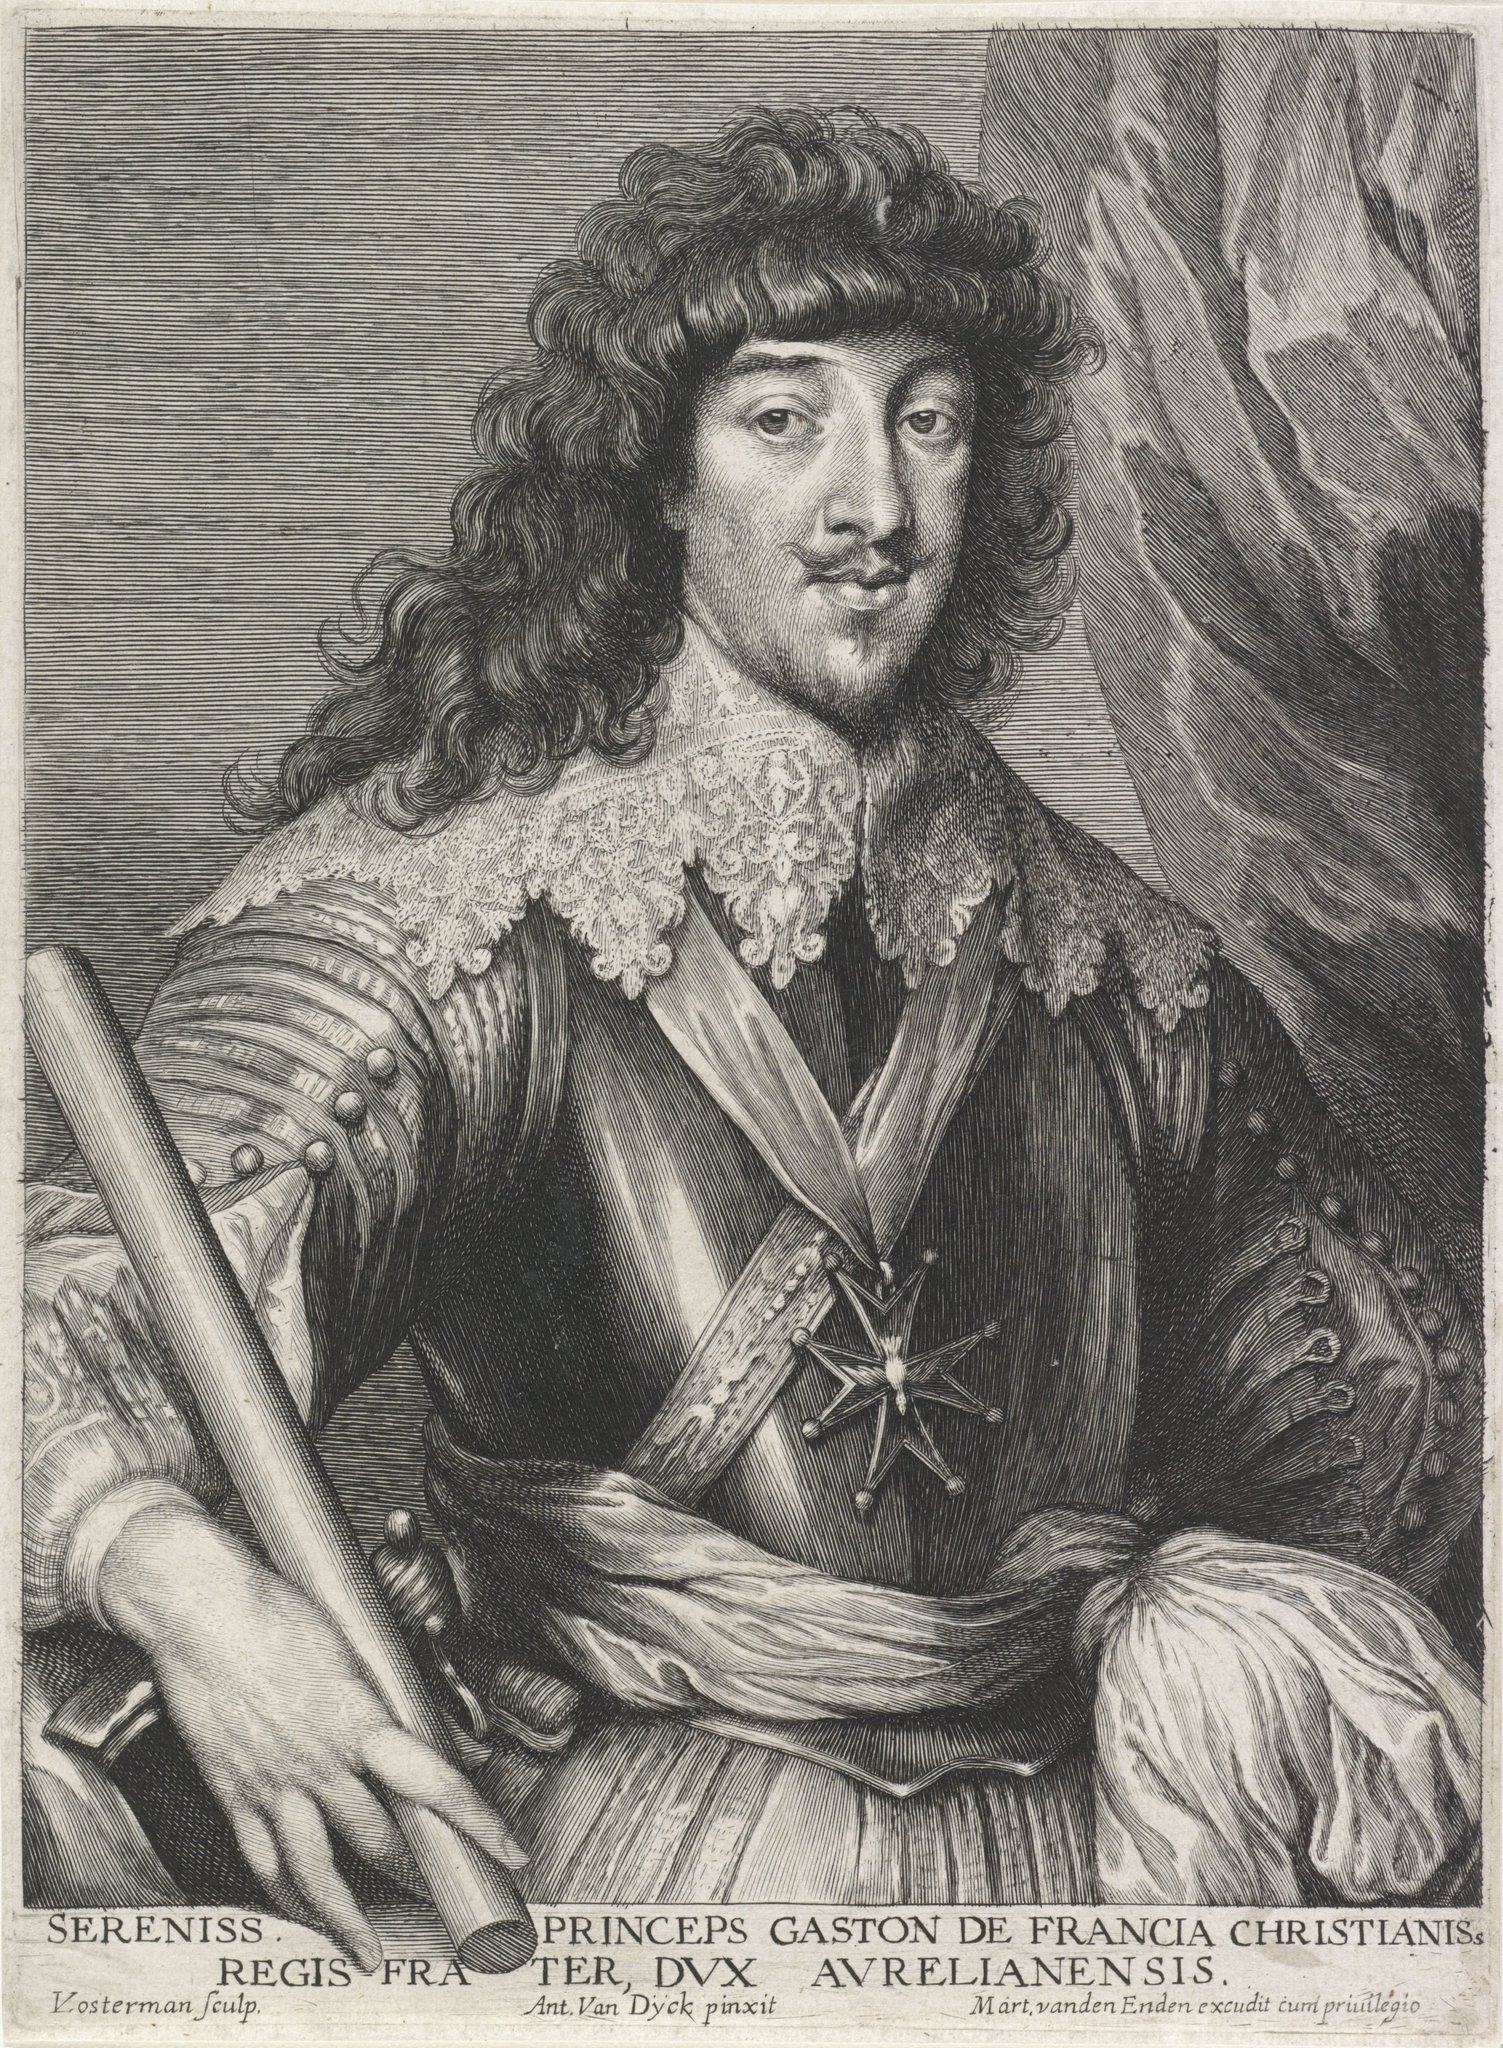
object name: print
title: Portret van Gaston Jean-Baptiste van Frankrijk, hertog van Orléans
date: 1630-1646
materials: paper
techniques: engraving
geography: antwerp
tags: gaston jean-baptiste hertog van orléans, baton of general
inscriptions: collector's mark: Lugt 240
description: Prent gebruikt voor: Icones principum, virorum doctorum, pictorum, chalcographorum, statuariorum nec non amatorum pictoriae artis numero centum ab Ant. van Dyck ad vivum expressae ejusque sumptibus aeri incisae. Antwerpen: Gillis Hendricx, [1645-1646].